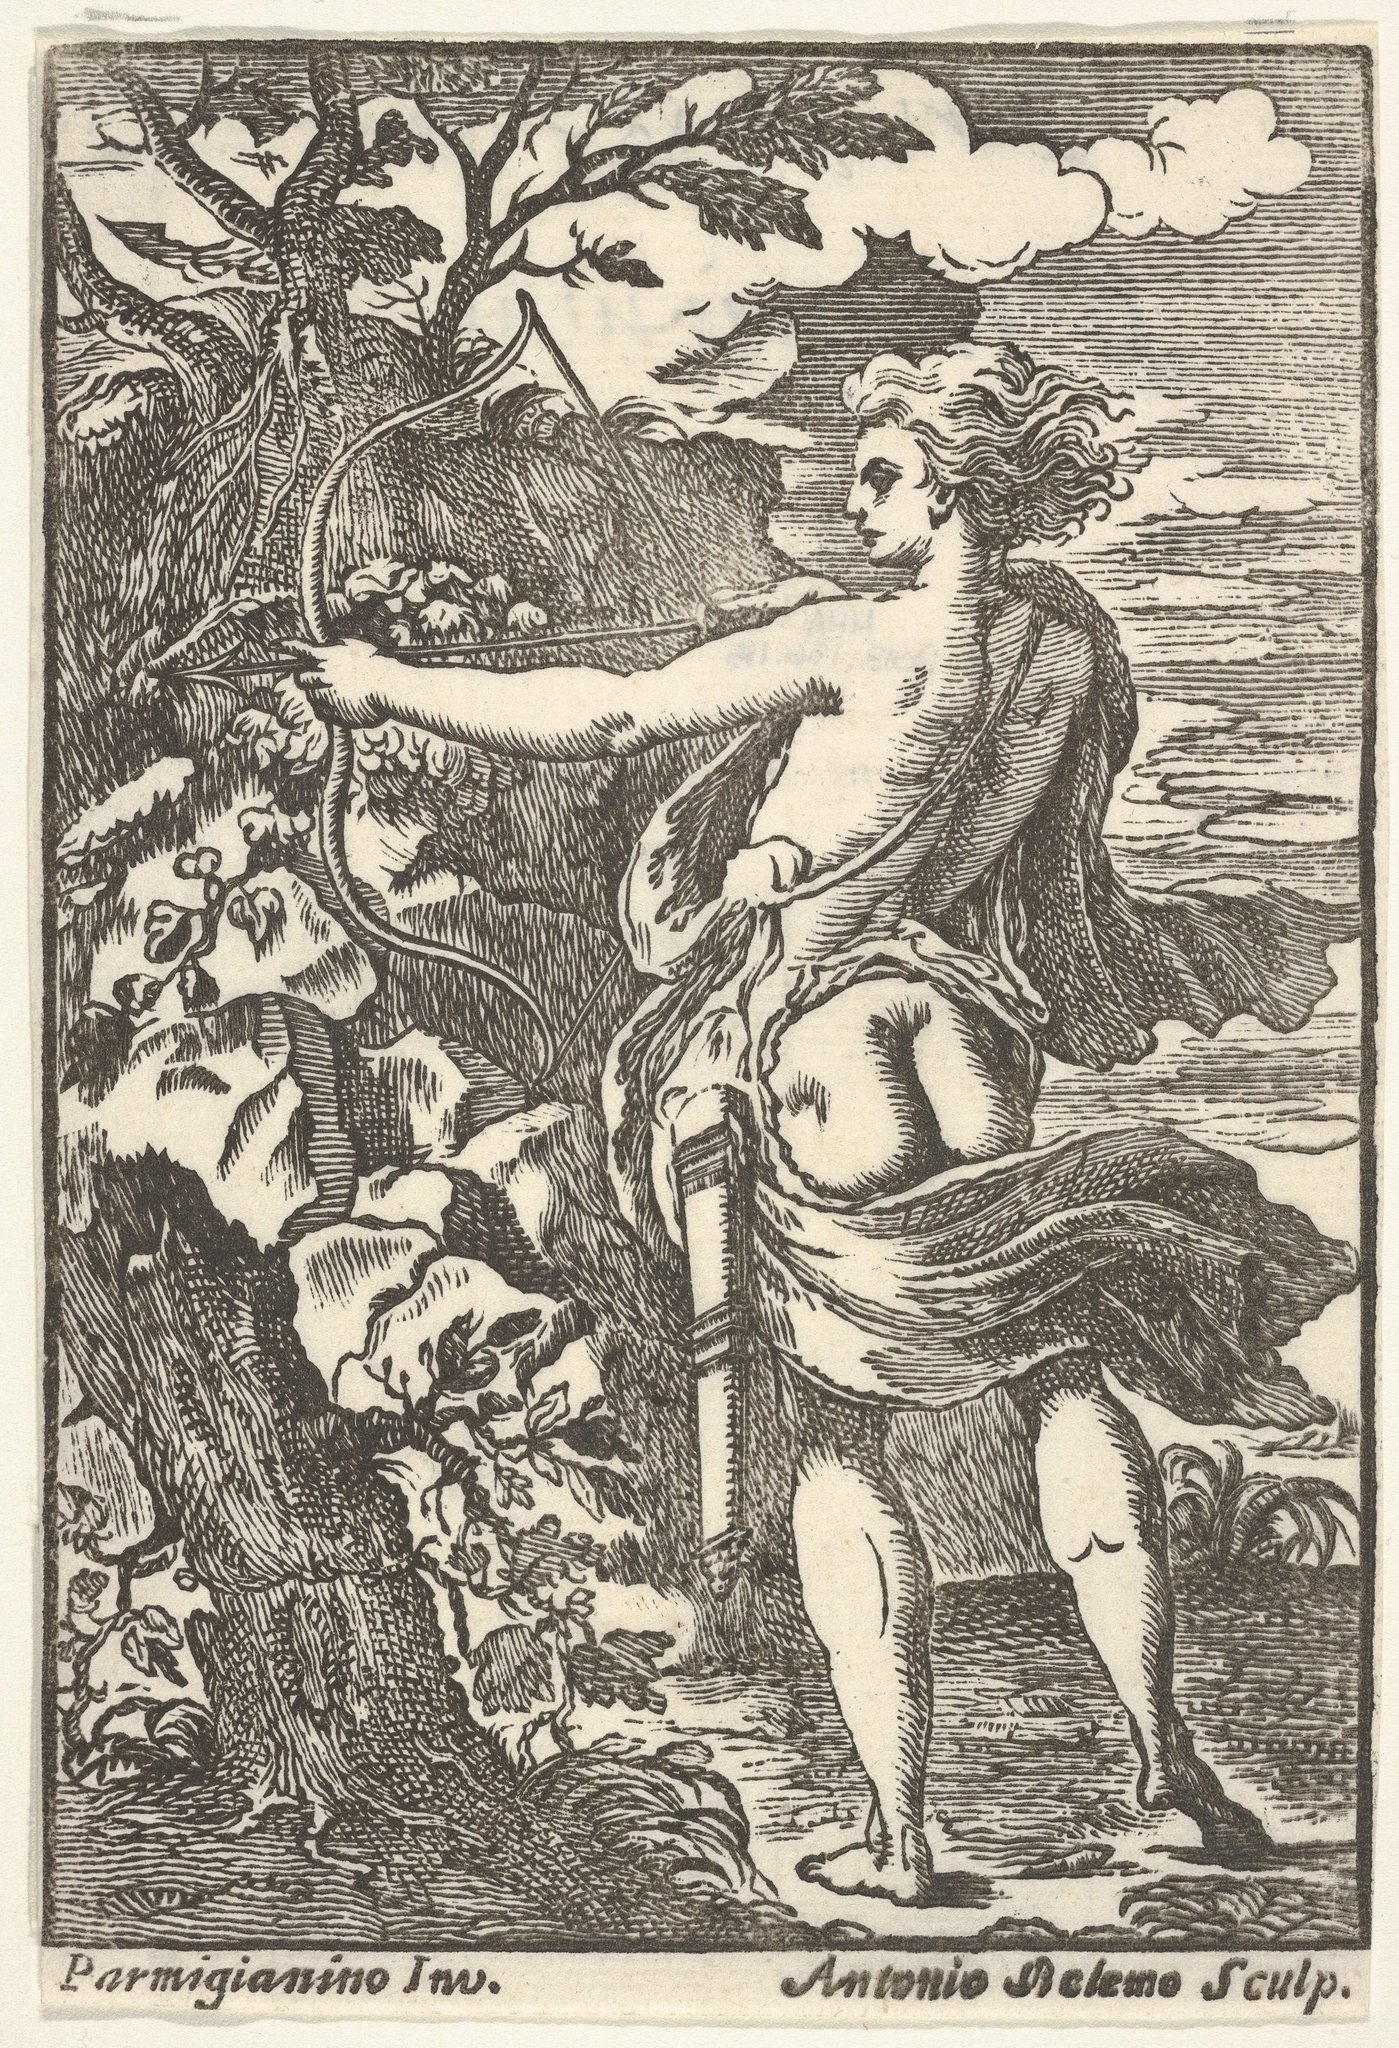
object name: print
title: Callisto hunting with drawn bow, after Parmigianino)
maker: antonio belemo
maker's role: artist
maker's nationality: italian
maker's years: 1700-1750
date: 1720-1740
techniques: engraving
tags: bow and arrow,hunting,nymphs